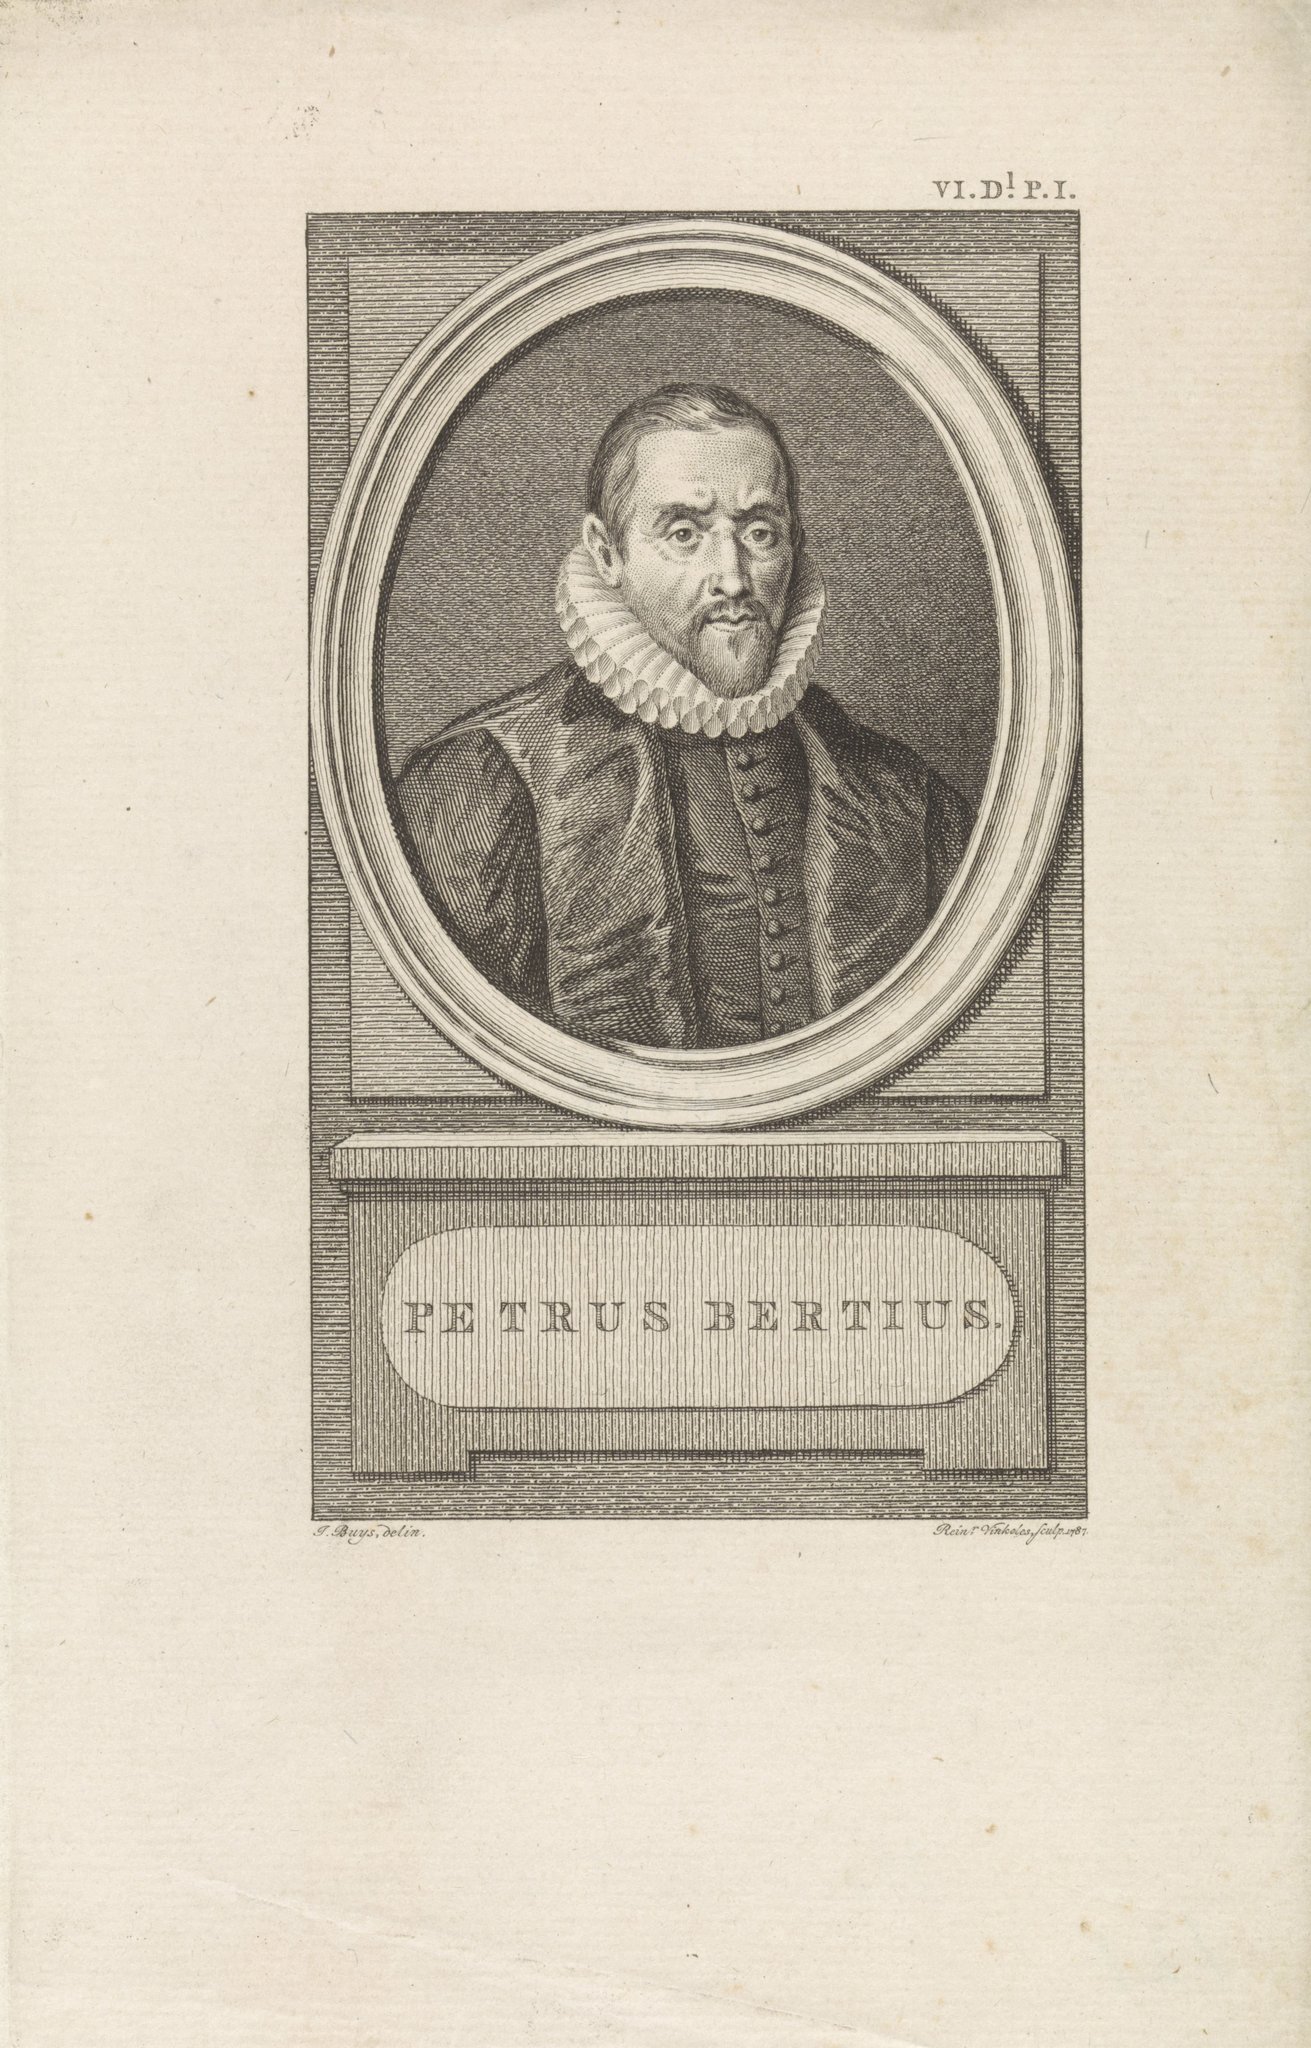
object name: book illustration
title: Portret van Pertrus Bertius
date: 1787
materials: paper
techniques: engraving, etching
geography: amsterdam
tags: paris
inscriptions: collector's mark: Lugt 2228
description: Prent gebruikt als boekillustratie in: Kok, Jacobus. Vaderlandsch woordenboek : met kaarten, plaaten en pourtraitten. Amsterdam: Johannes Allart, 1785-1796. Deel VI.